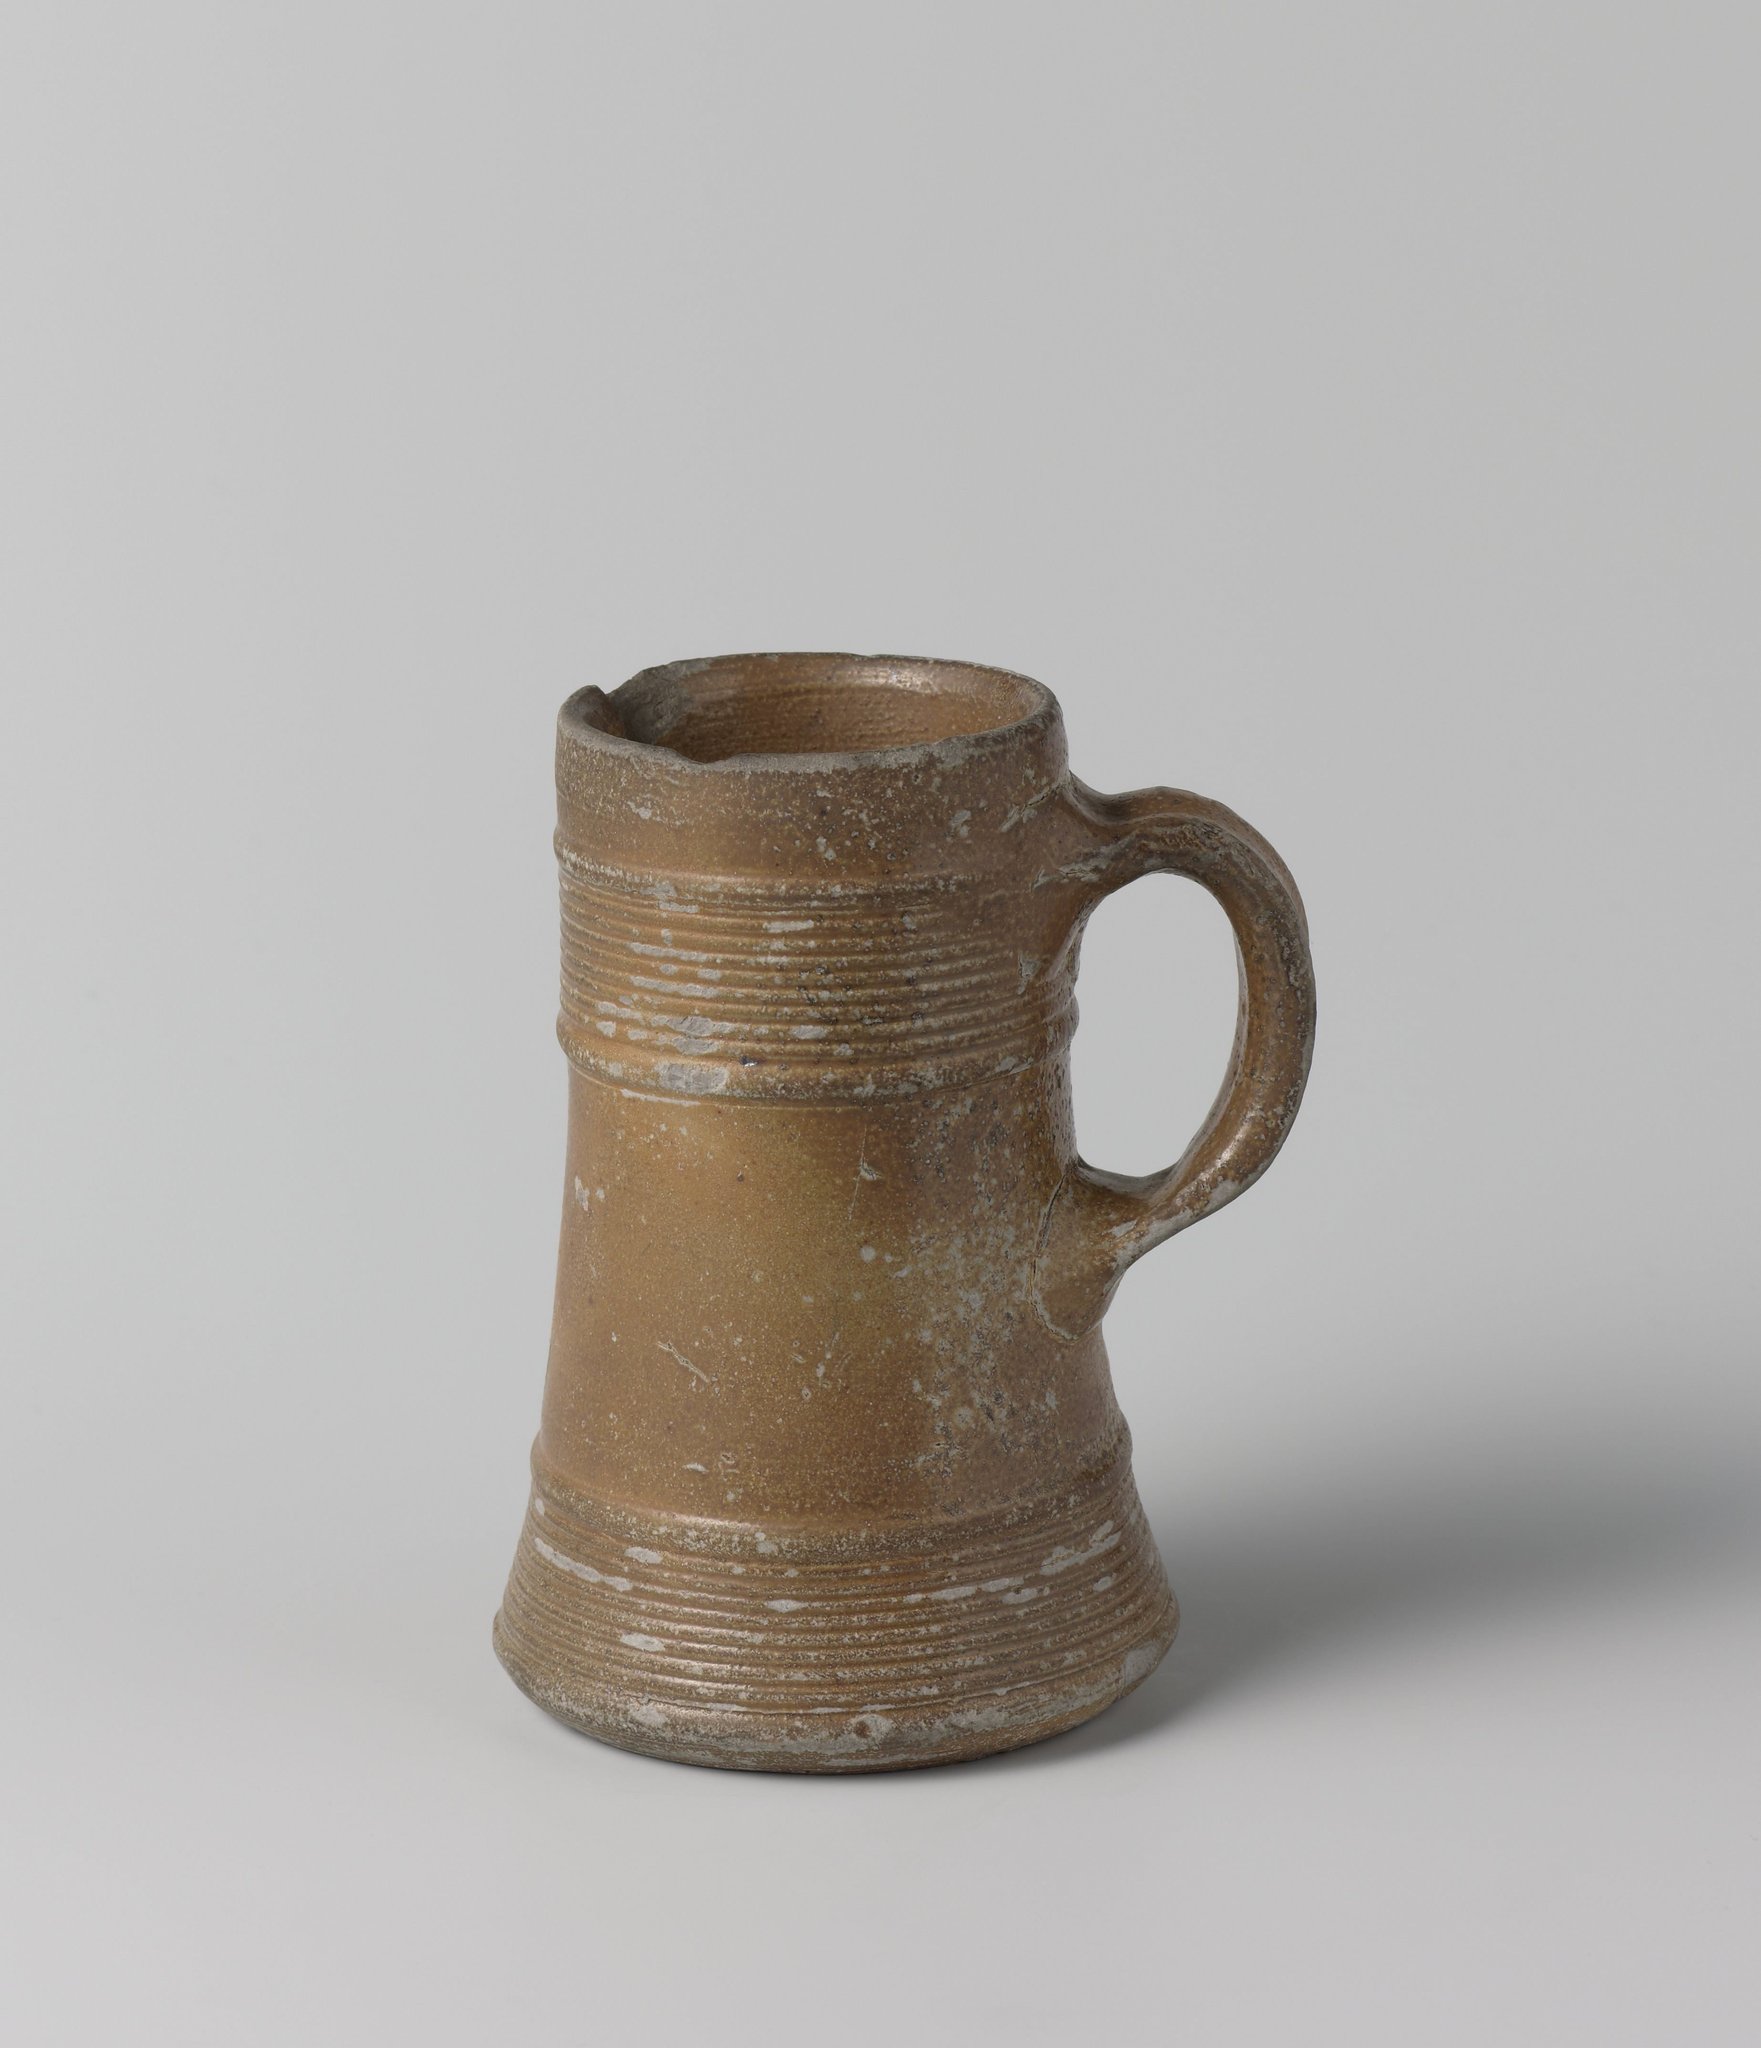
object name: cup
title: Ribbed tankard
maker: Anonymous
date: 1550-1599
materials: engobe, glaze, stoneware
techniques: firing, forming, relief, turning, vitrification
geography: raeren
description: Bierpul van steengoed met een cilindrisch, naar onder toe spreidend lichaam en C-vormig oor. Bedekt met een bruine engobe. Onder de rand en boven de voet een brede, geribde band. Raeren.